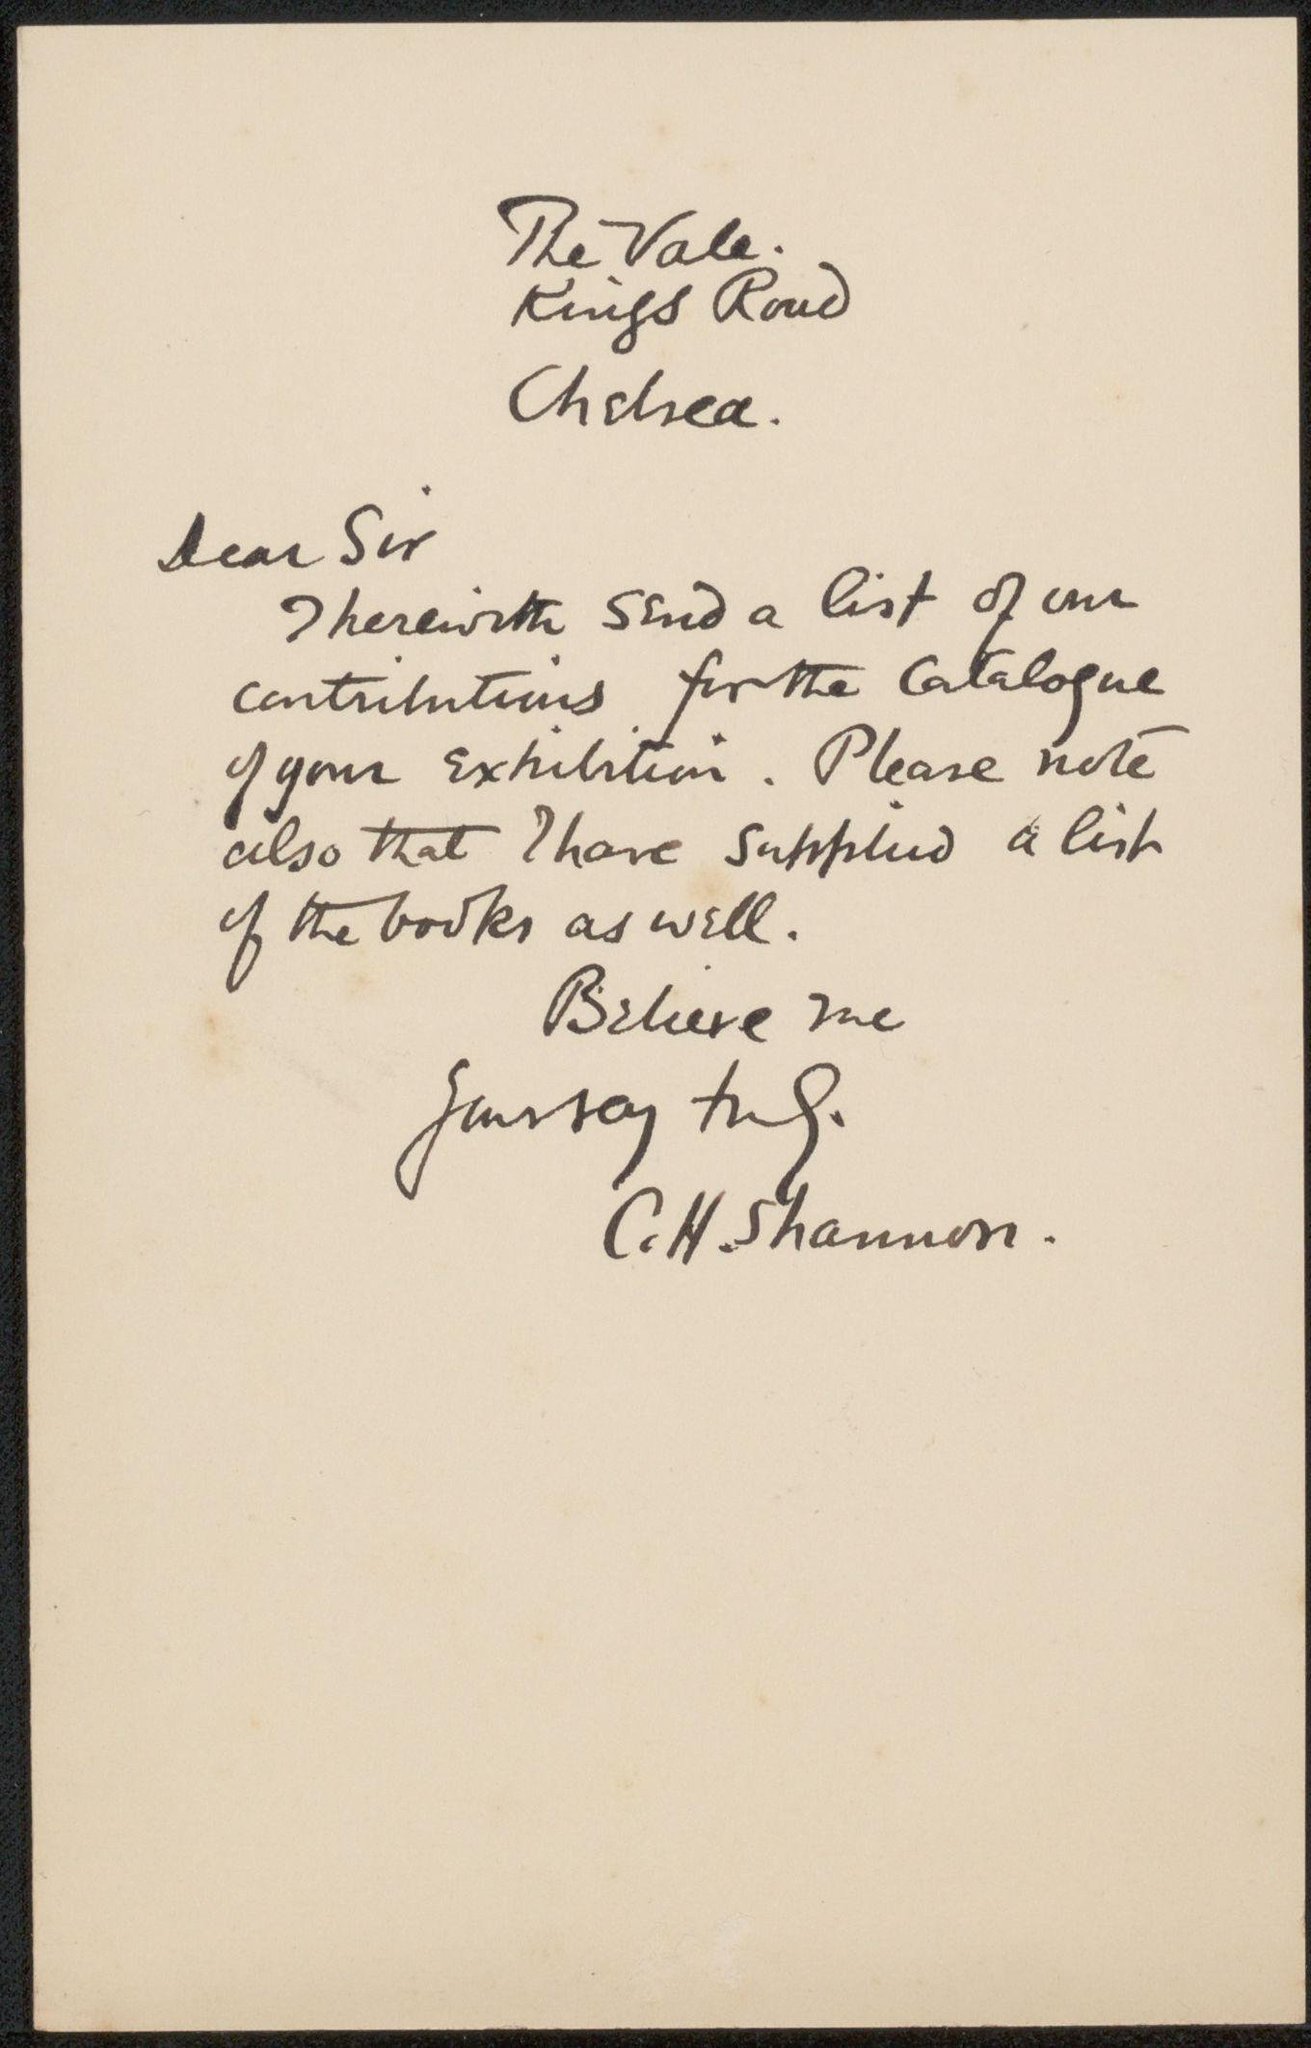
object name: letter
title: Brief aan Philip Zilcken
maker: charles haslewood shannon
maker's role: draughtsman, print maker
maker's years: 1865-1937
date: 1875-1930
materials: ink, paper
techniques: pen, writing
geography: chelsea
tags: the hague, painter, philip zilcken, exhibition ~ art, printed matter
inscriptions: collector's mark: ‘RPK’